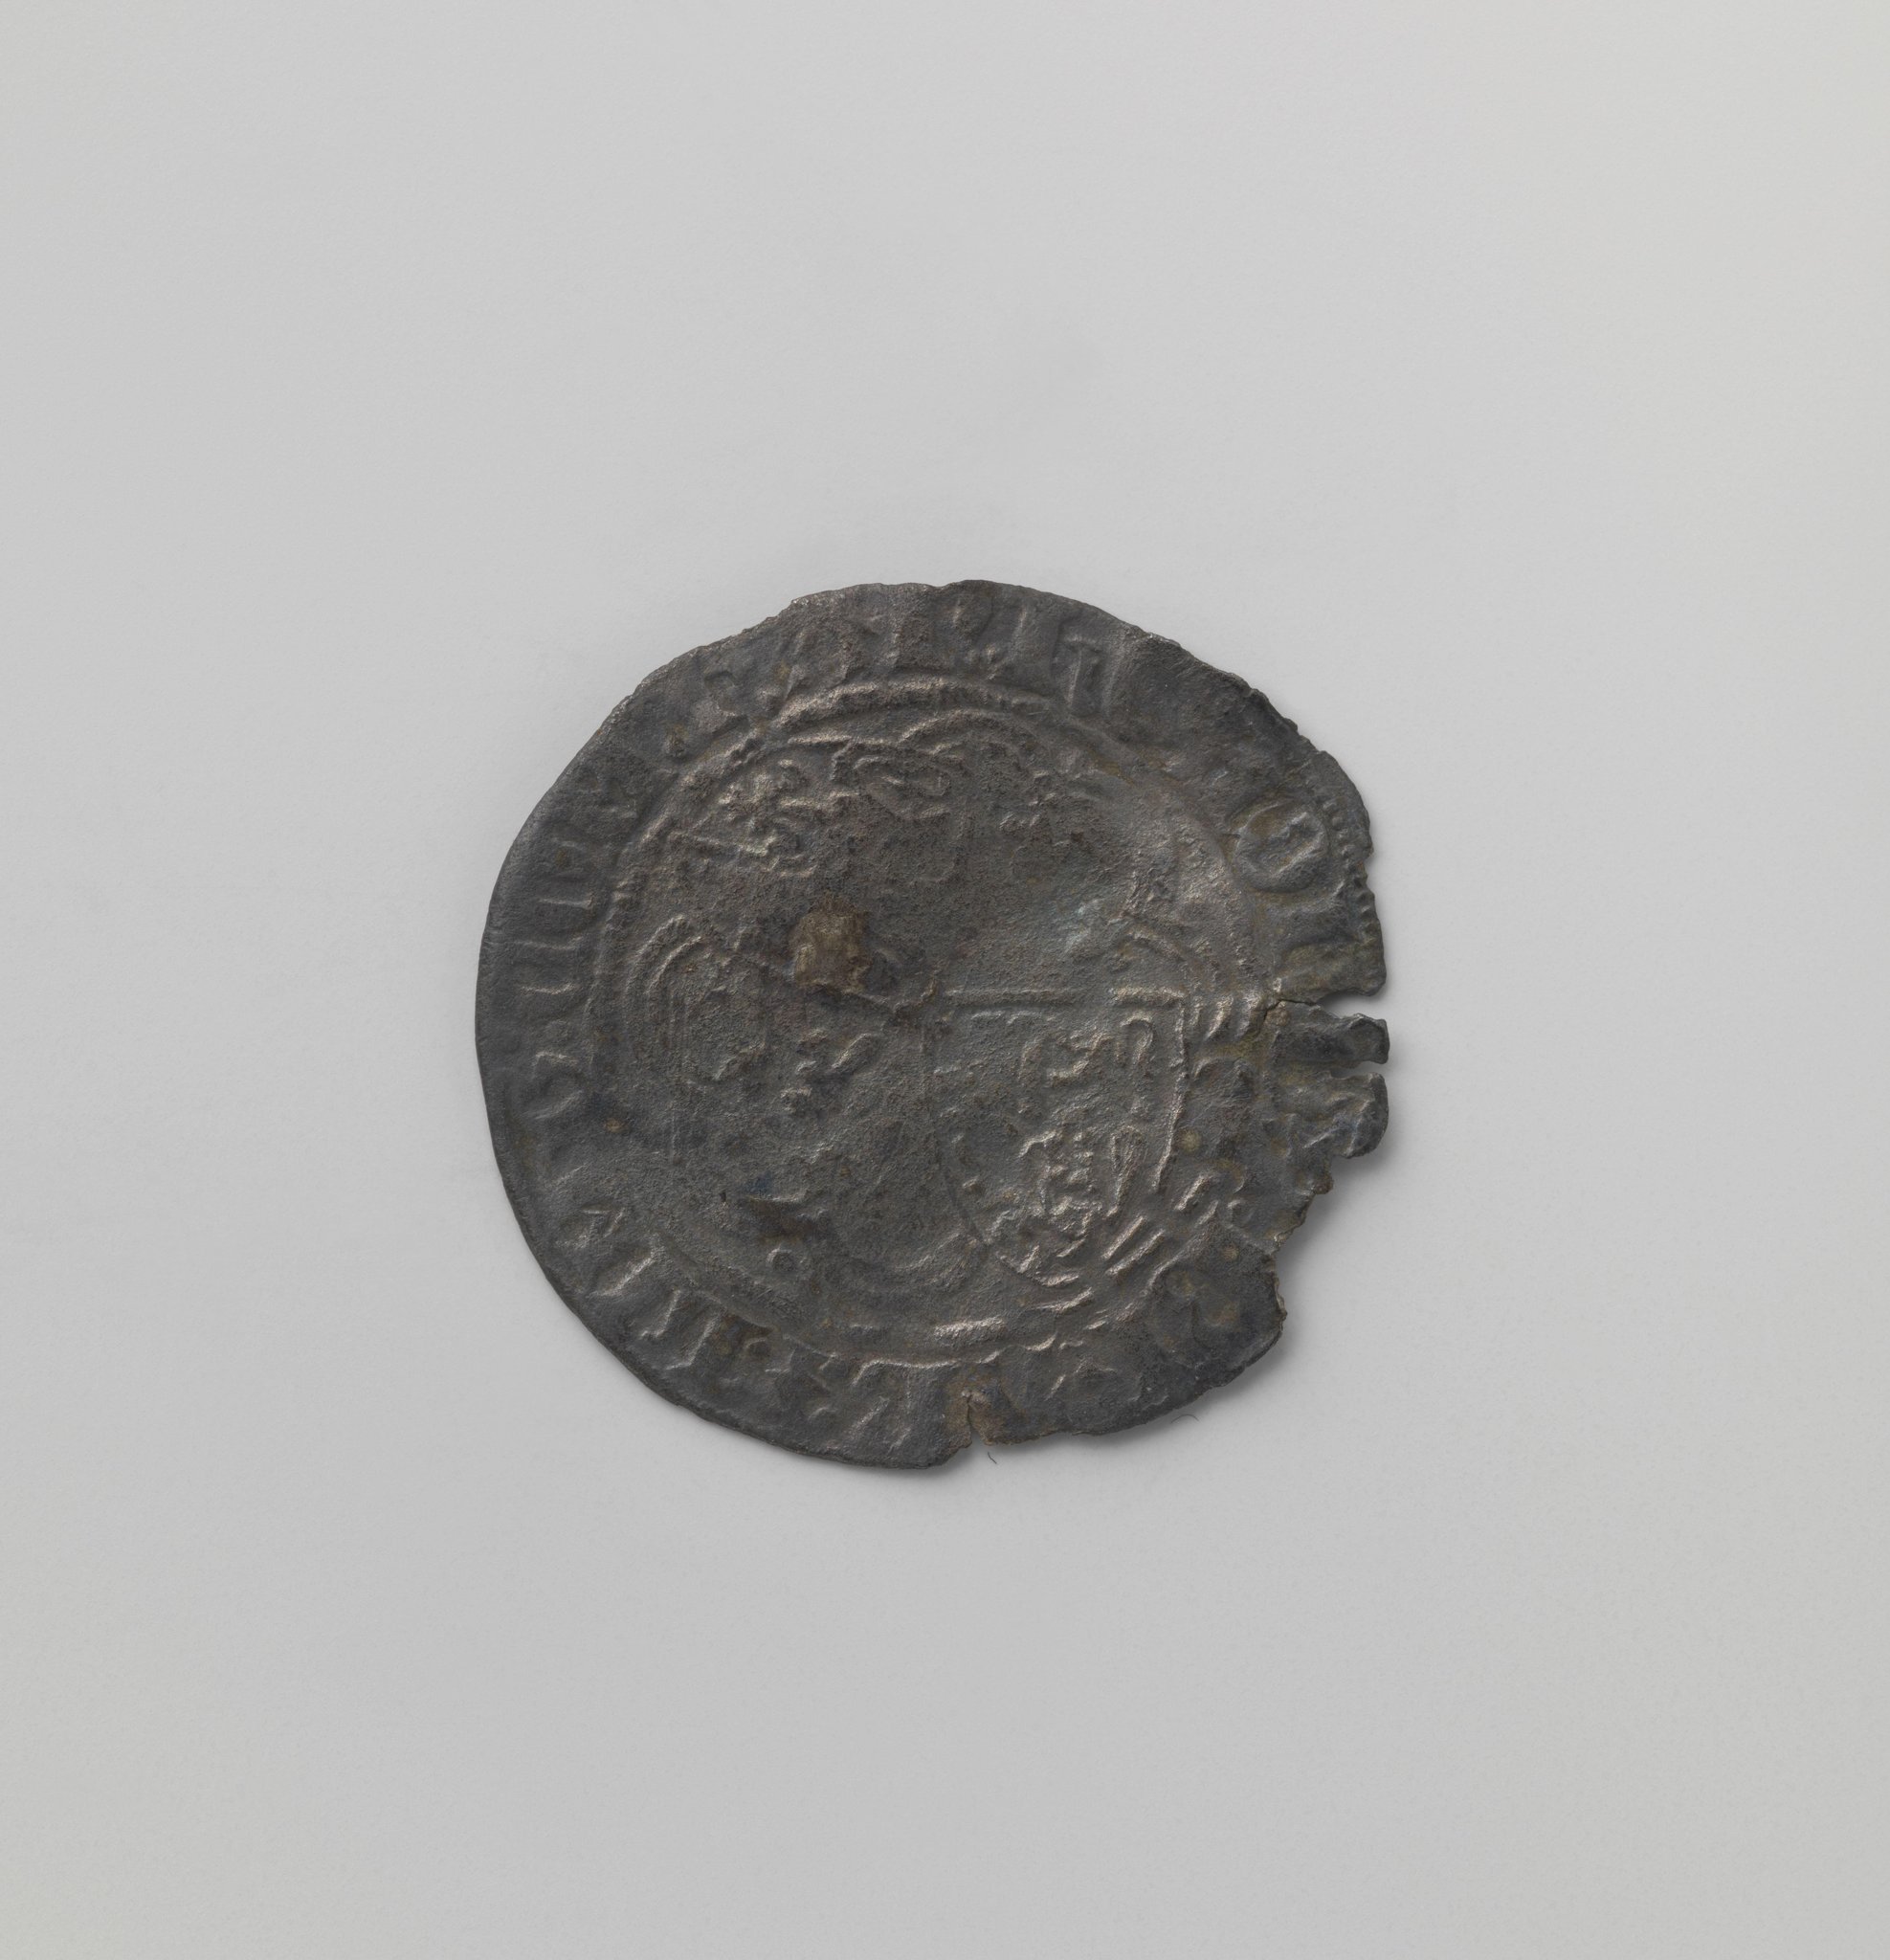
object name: coin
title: Halve groot drielander uit Brabant van Jan IV, 1415-1427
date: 1415-1427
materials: silver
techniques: striking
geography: brussels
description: Zilveren munt. Voorzijde: in een veelpas twee schuin naar elkaar toegewende wapenschilden, waartussen lelie. Keerzijde: kort gevoet kruis, in eerste hoek een lelie en in derde hoek een leeuw. Dubbel omschrift.